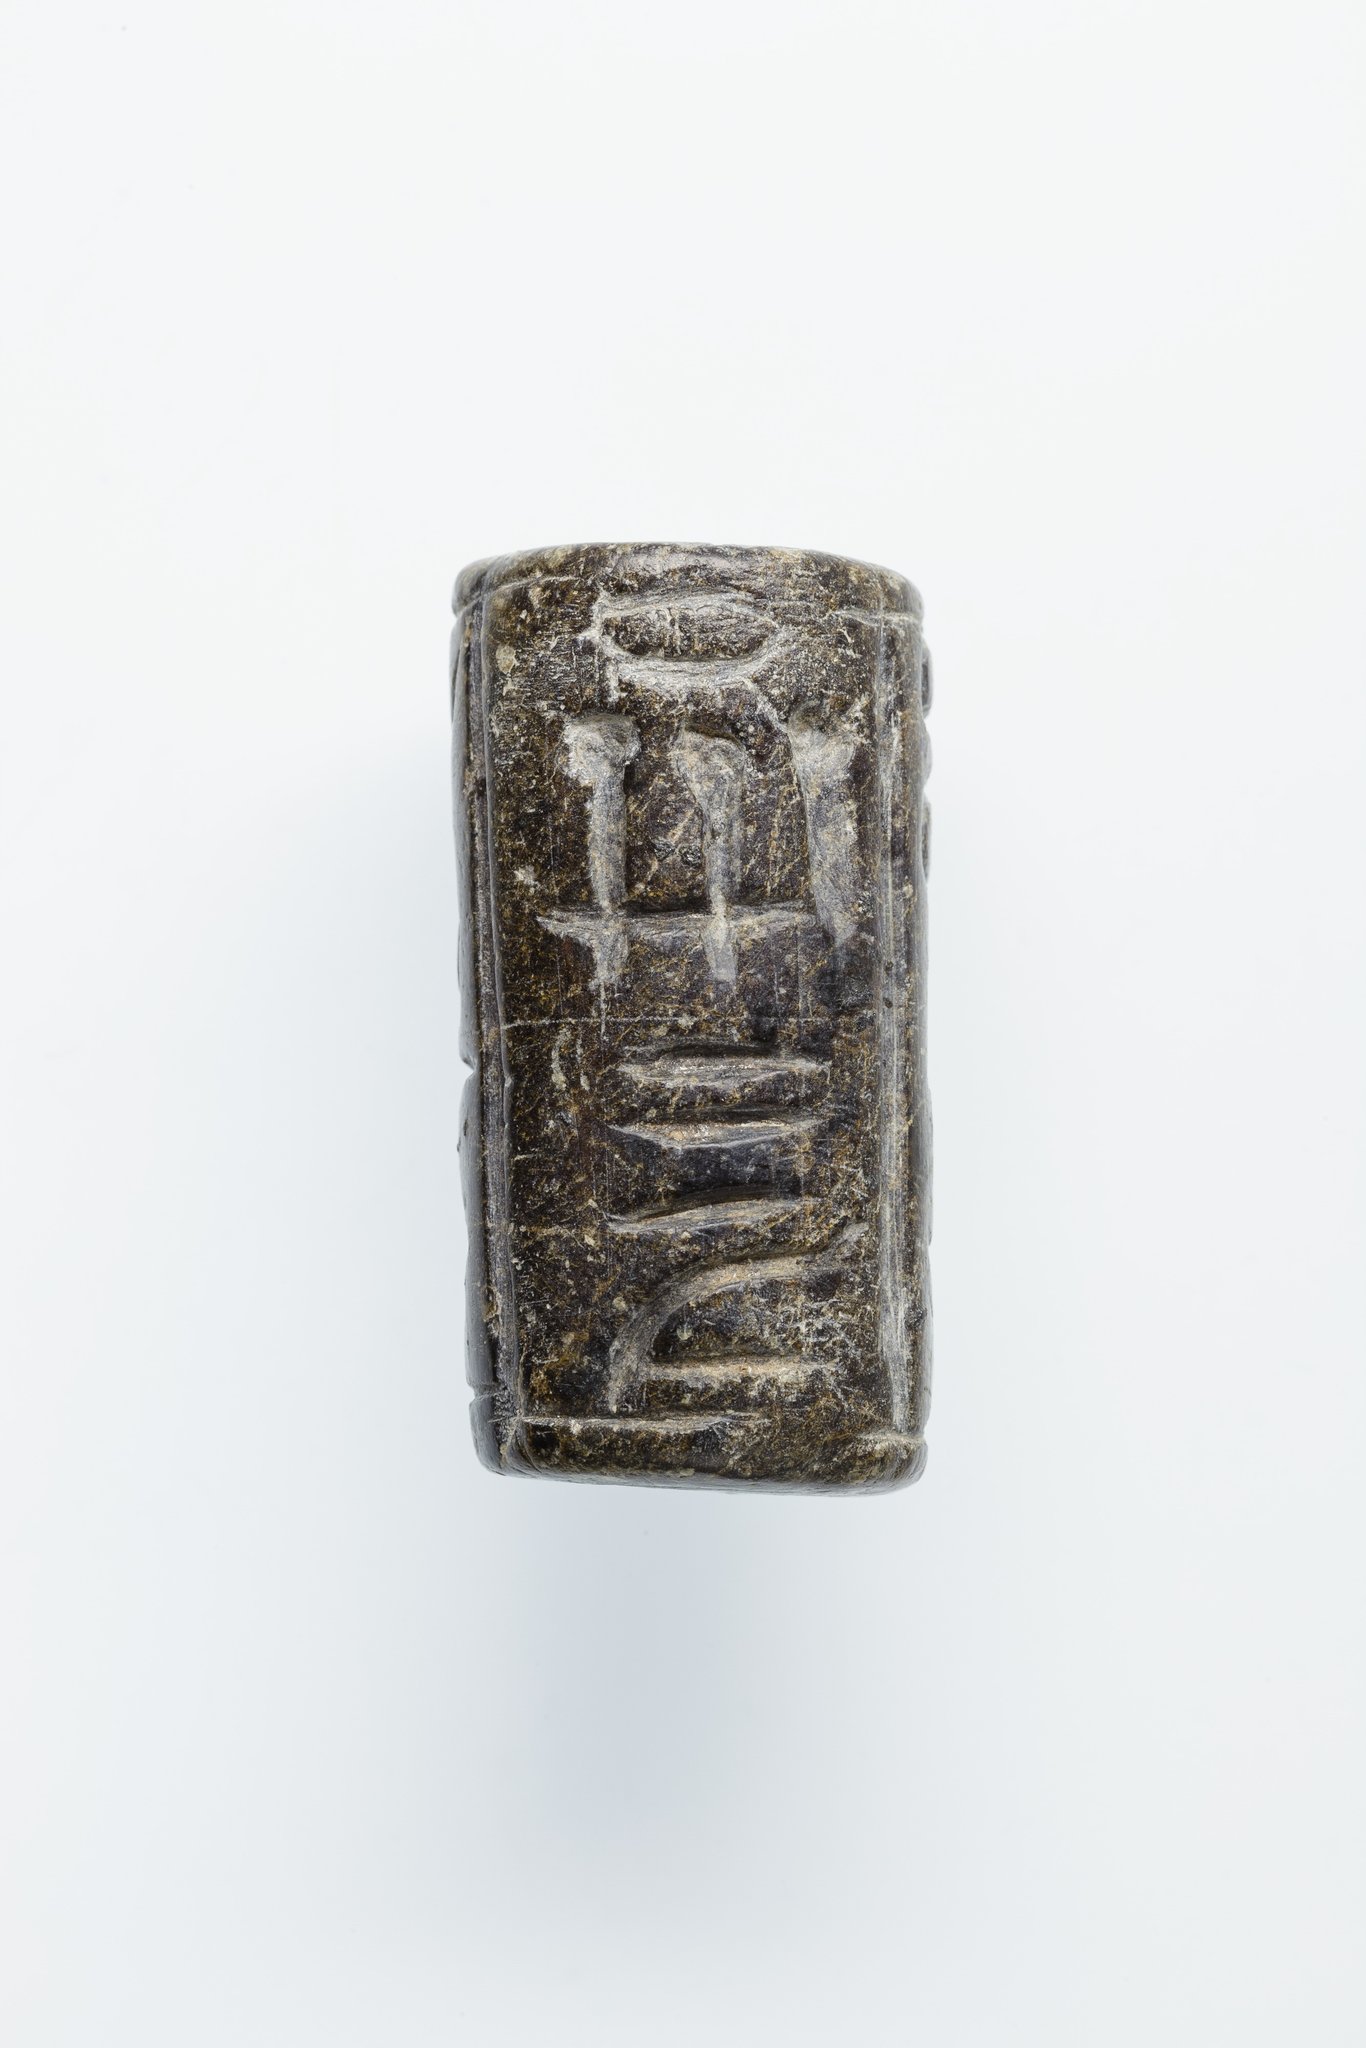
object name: cylinder seal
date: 2649-2100 BCE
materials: stone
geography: egypt